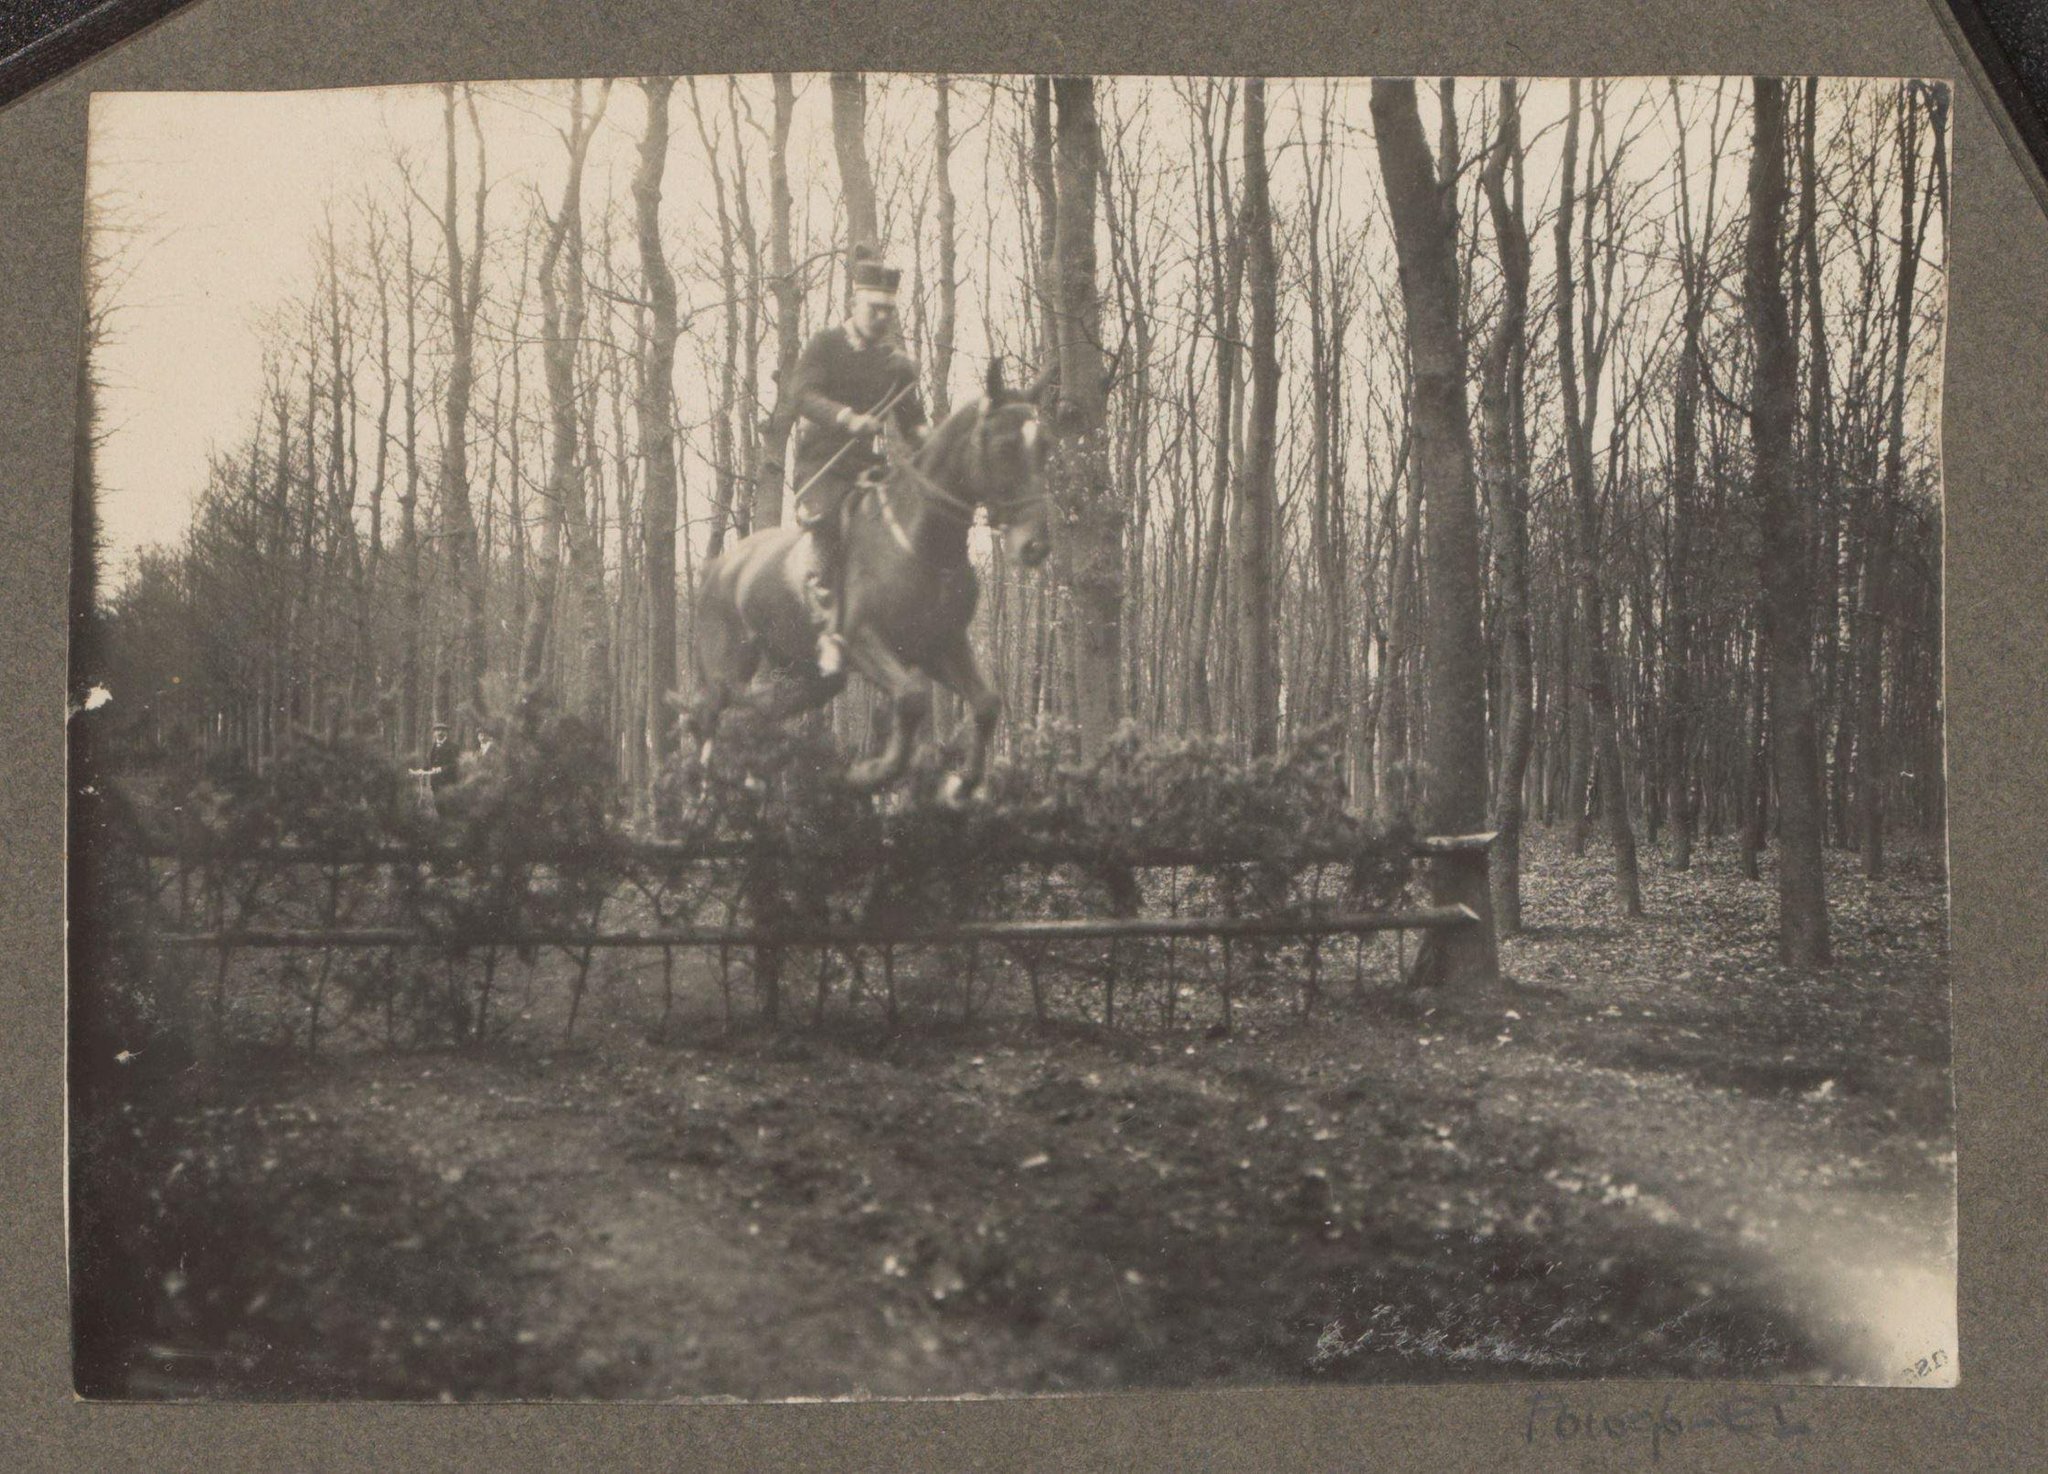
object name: album leaf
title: Ruitertafereel op Koninklijke Houtvesterij Het Loo: ruiter neemt hindernis op een bospad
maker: Anonymous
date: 1900-1925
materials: photographic support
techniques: gelatin silver print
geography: het loo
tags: riding a horse, ass, or mule; rider, horseman, hunting, chase, hunting-ground, forest path or lane, jumping (horse in motion)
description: Onderdeel van Fotoalbum van de heer Brams, opperhoutvester van koningin Wilhelmina op Koninklijke Houtvesterij Het Loo.